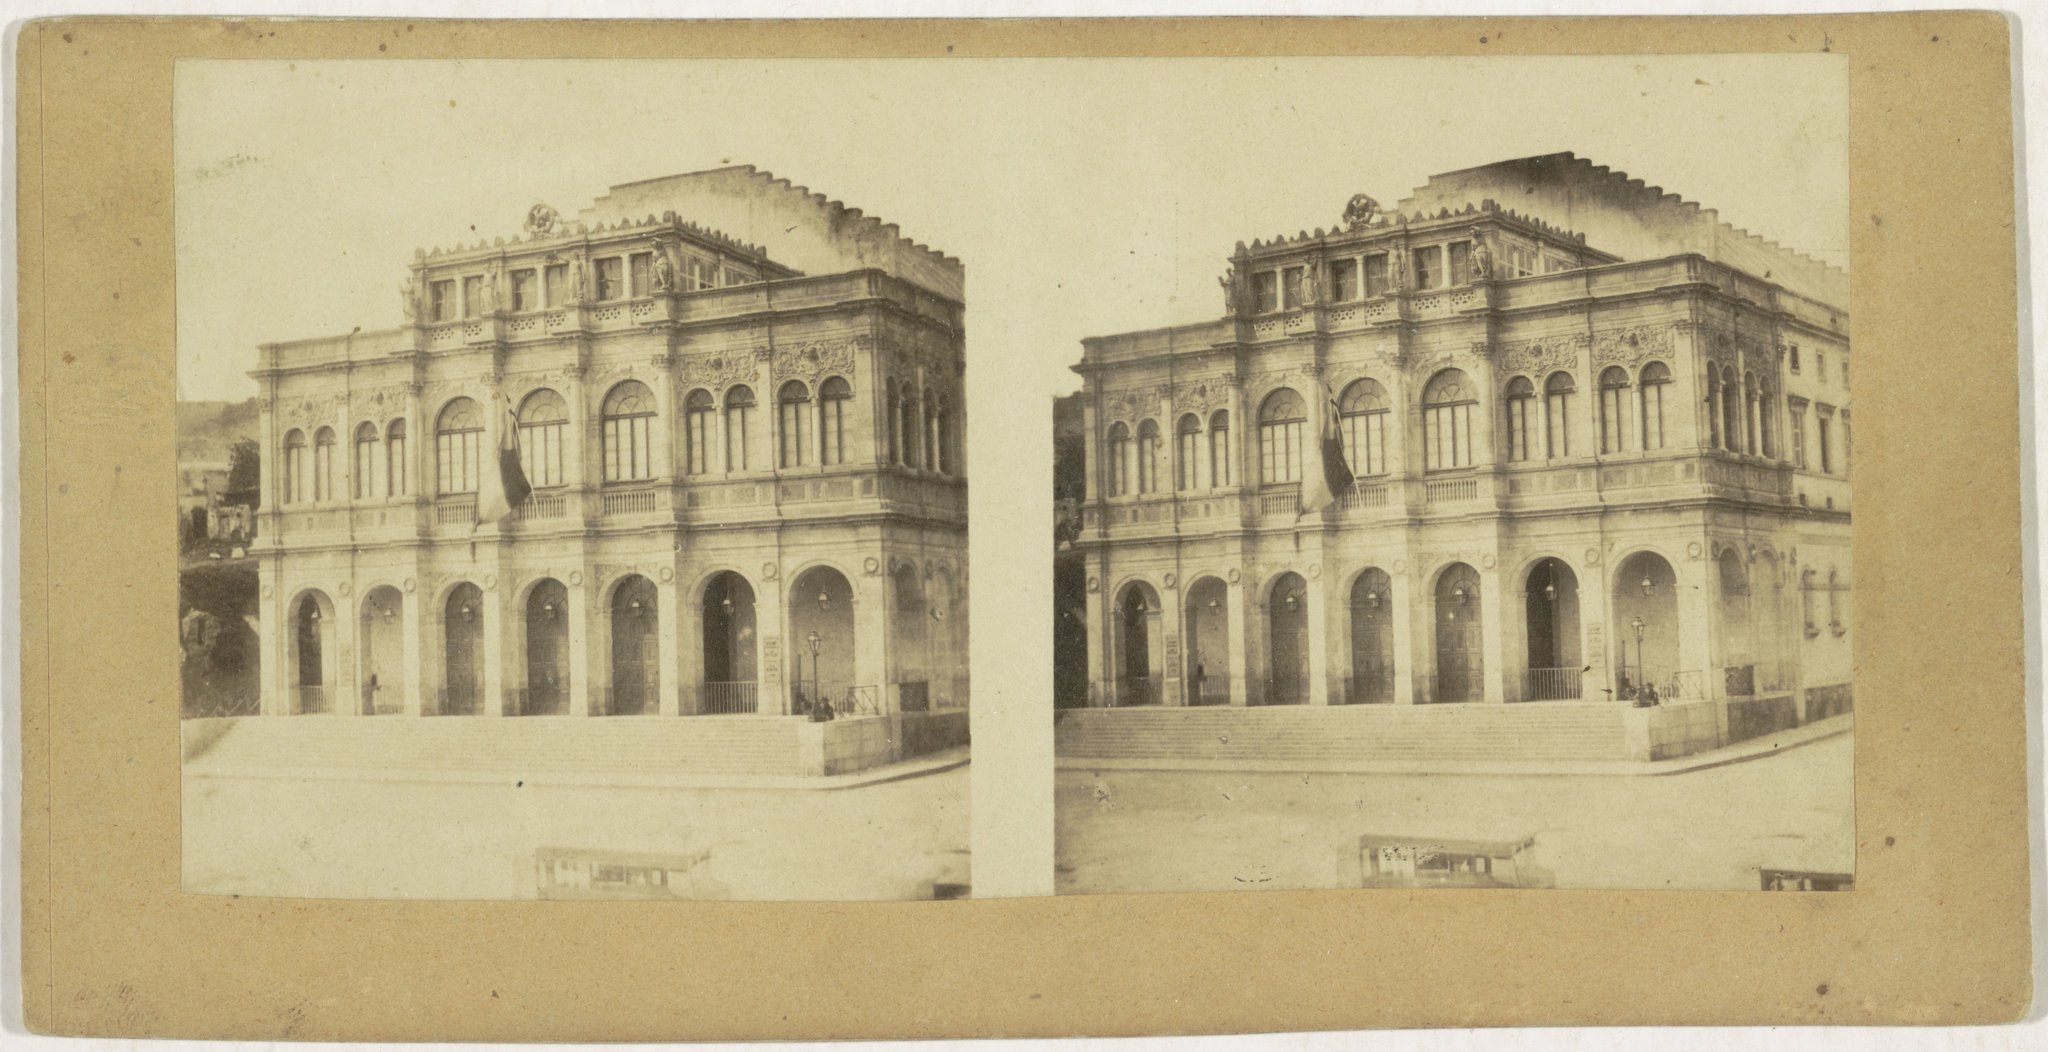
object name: stereograph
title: theatre Impérial, à Alger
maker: Anonymous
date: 1857-1863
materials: cardboard, paper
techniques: albumen print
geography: algiers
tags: theatre (building)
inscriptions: monogram: ‘LM’, inscription: ‘G LC [onz]’